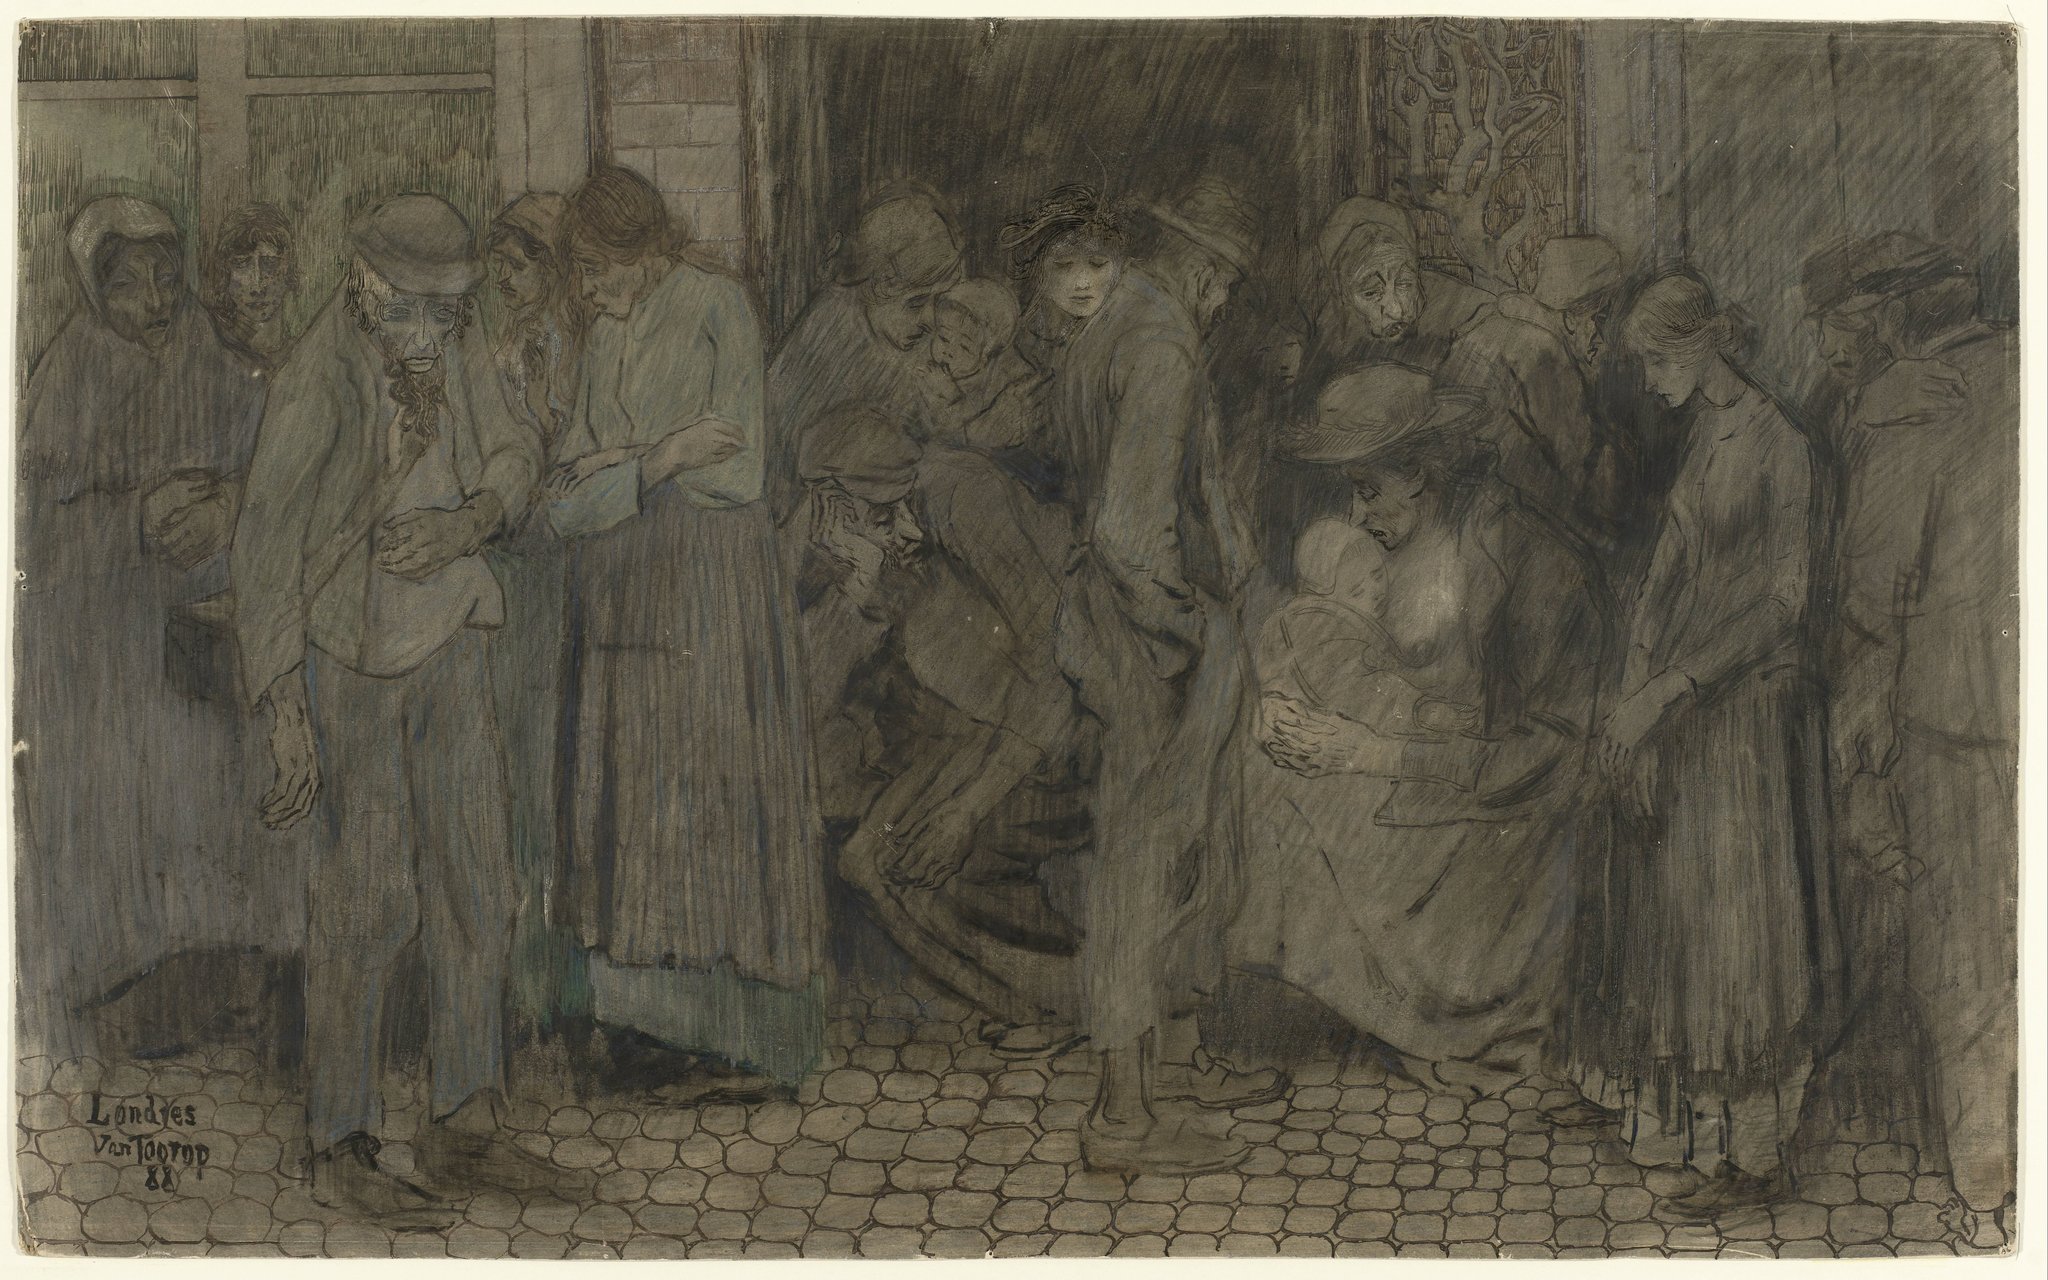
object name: drawing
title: Straattafereel in Londen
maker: jan toorop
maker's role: draughtsman, painter, print maker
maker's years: 1858-1928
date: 1888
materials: cardboard, chalk, ink, pencil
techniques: pen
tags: outcasts, pariahs, united kingdom, london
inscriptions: inscription: ‘La porte d'un Rufuge’, date: ‘88’